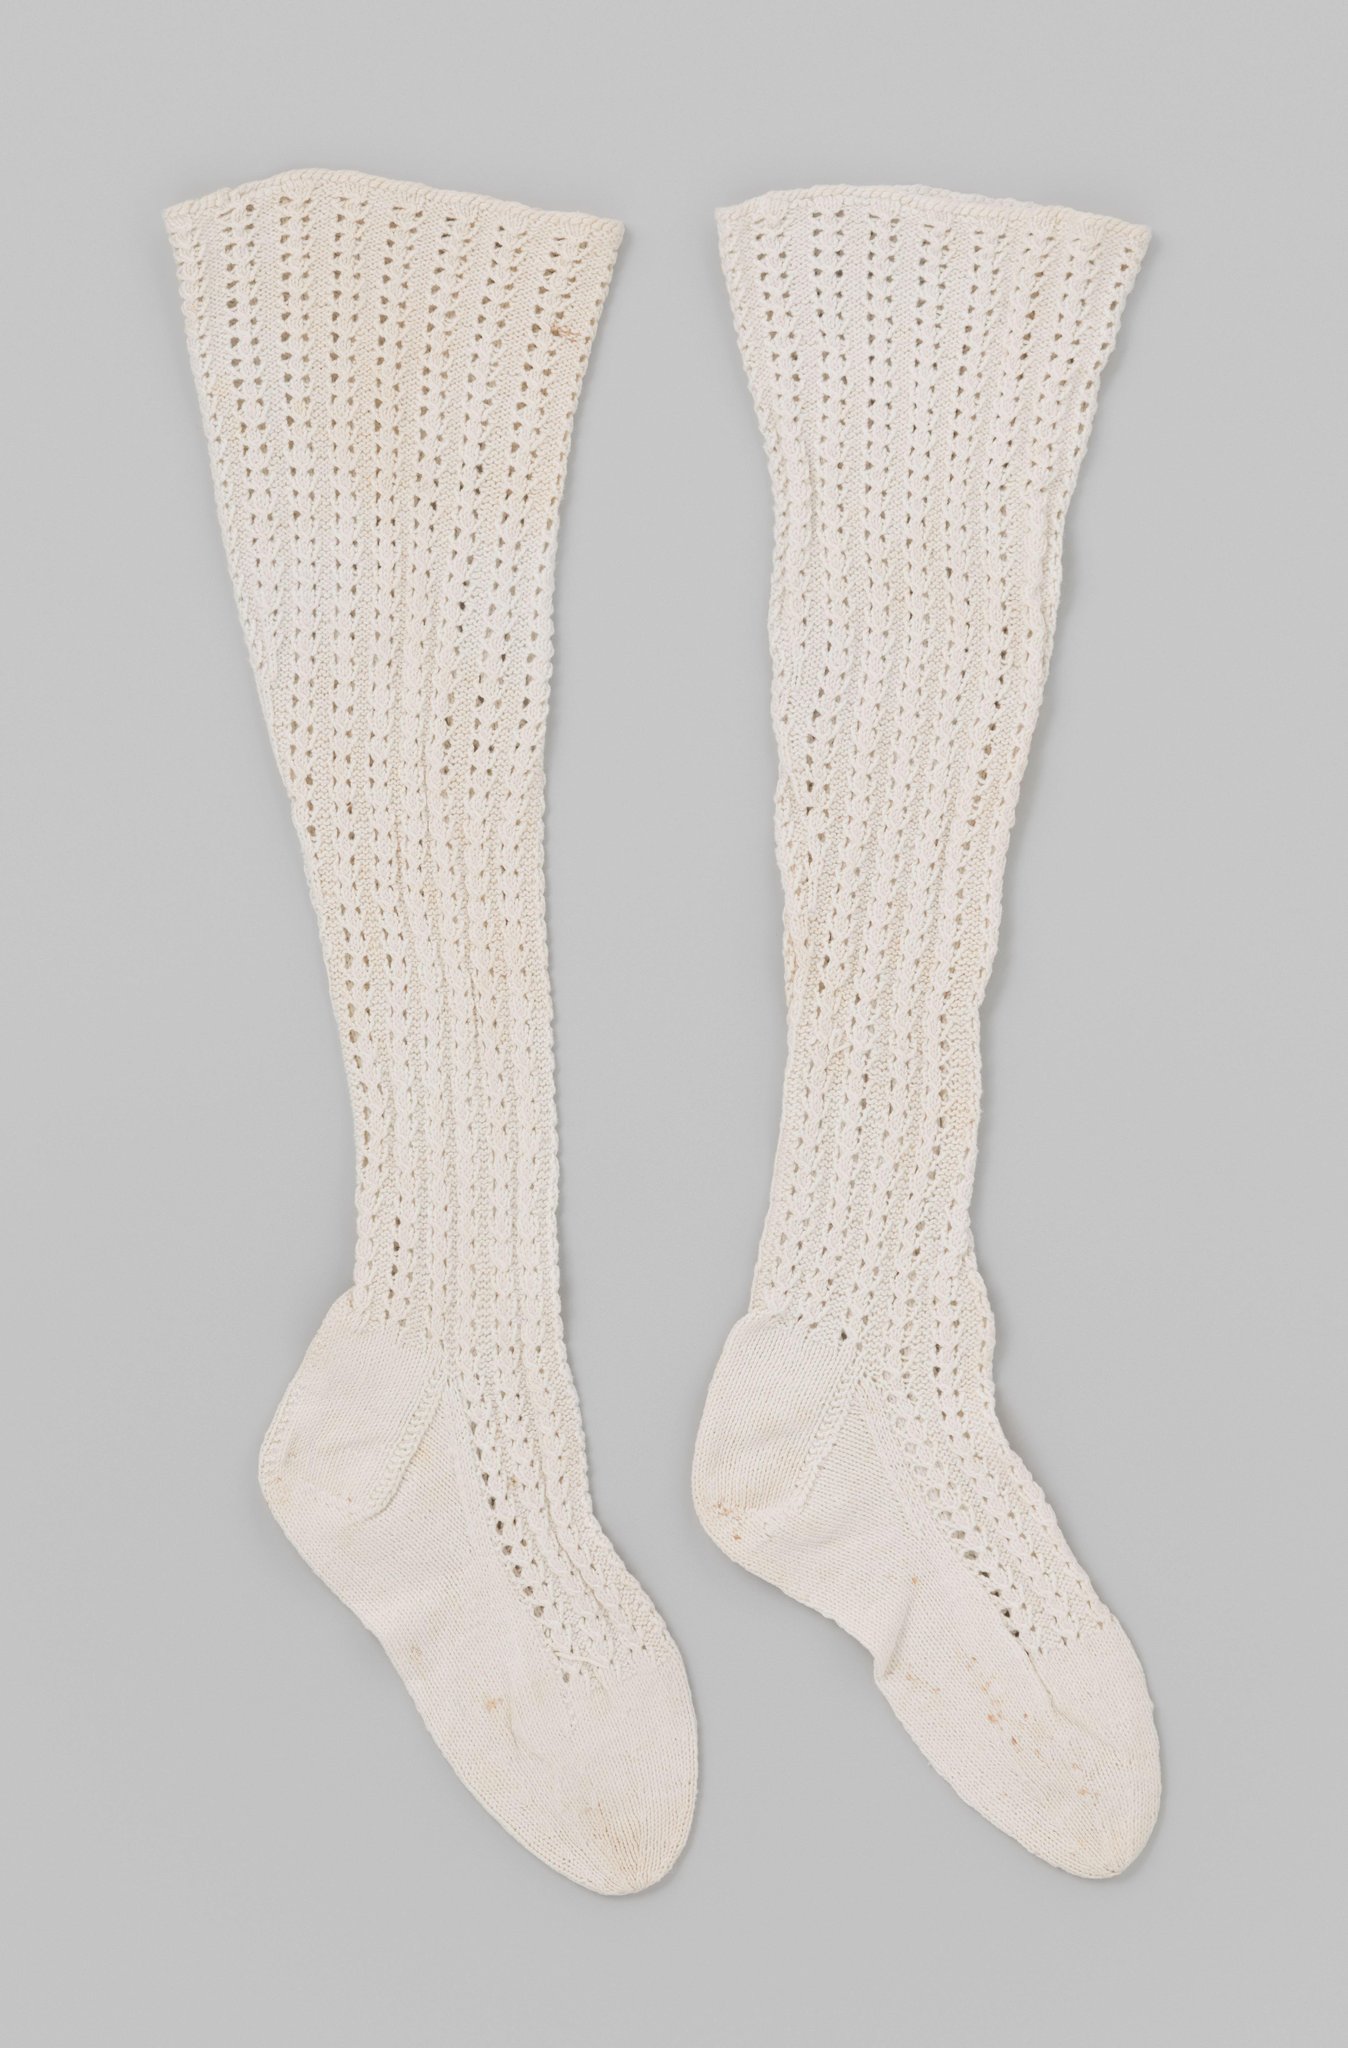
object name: childrenswear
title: Kous van witte katoenen tricot, met, op de voet na, een ajour patroon met kruiststeken in verticale banen, zonder boord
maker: Anonymous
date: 1830-1840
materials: cotton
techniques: cross stitching, embroidery, knitting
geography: netherlands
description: Kous van dikke witte katoenen tricot, met, op de voet na, een ajour patroon met kruiststeken in verticale banen, zonder boord.